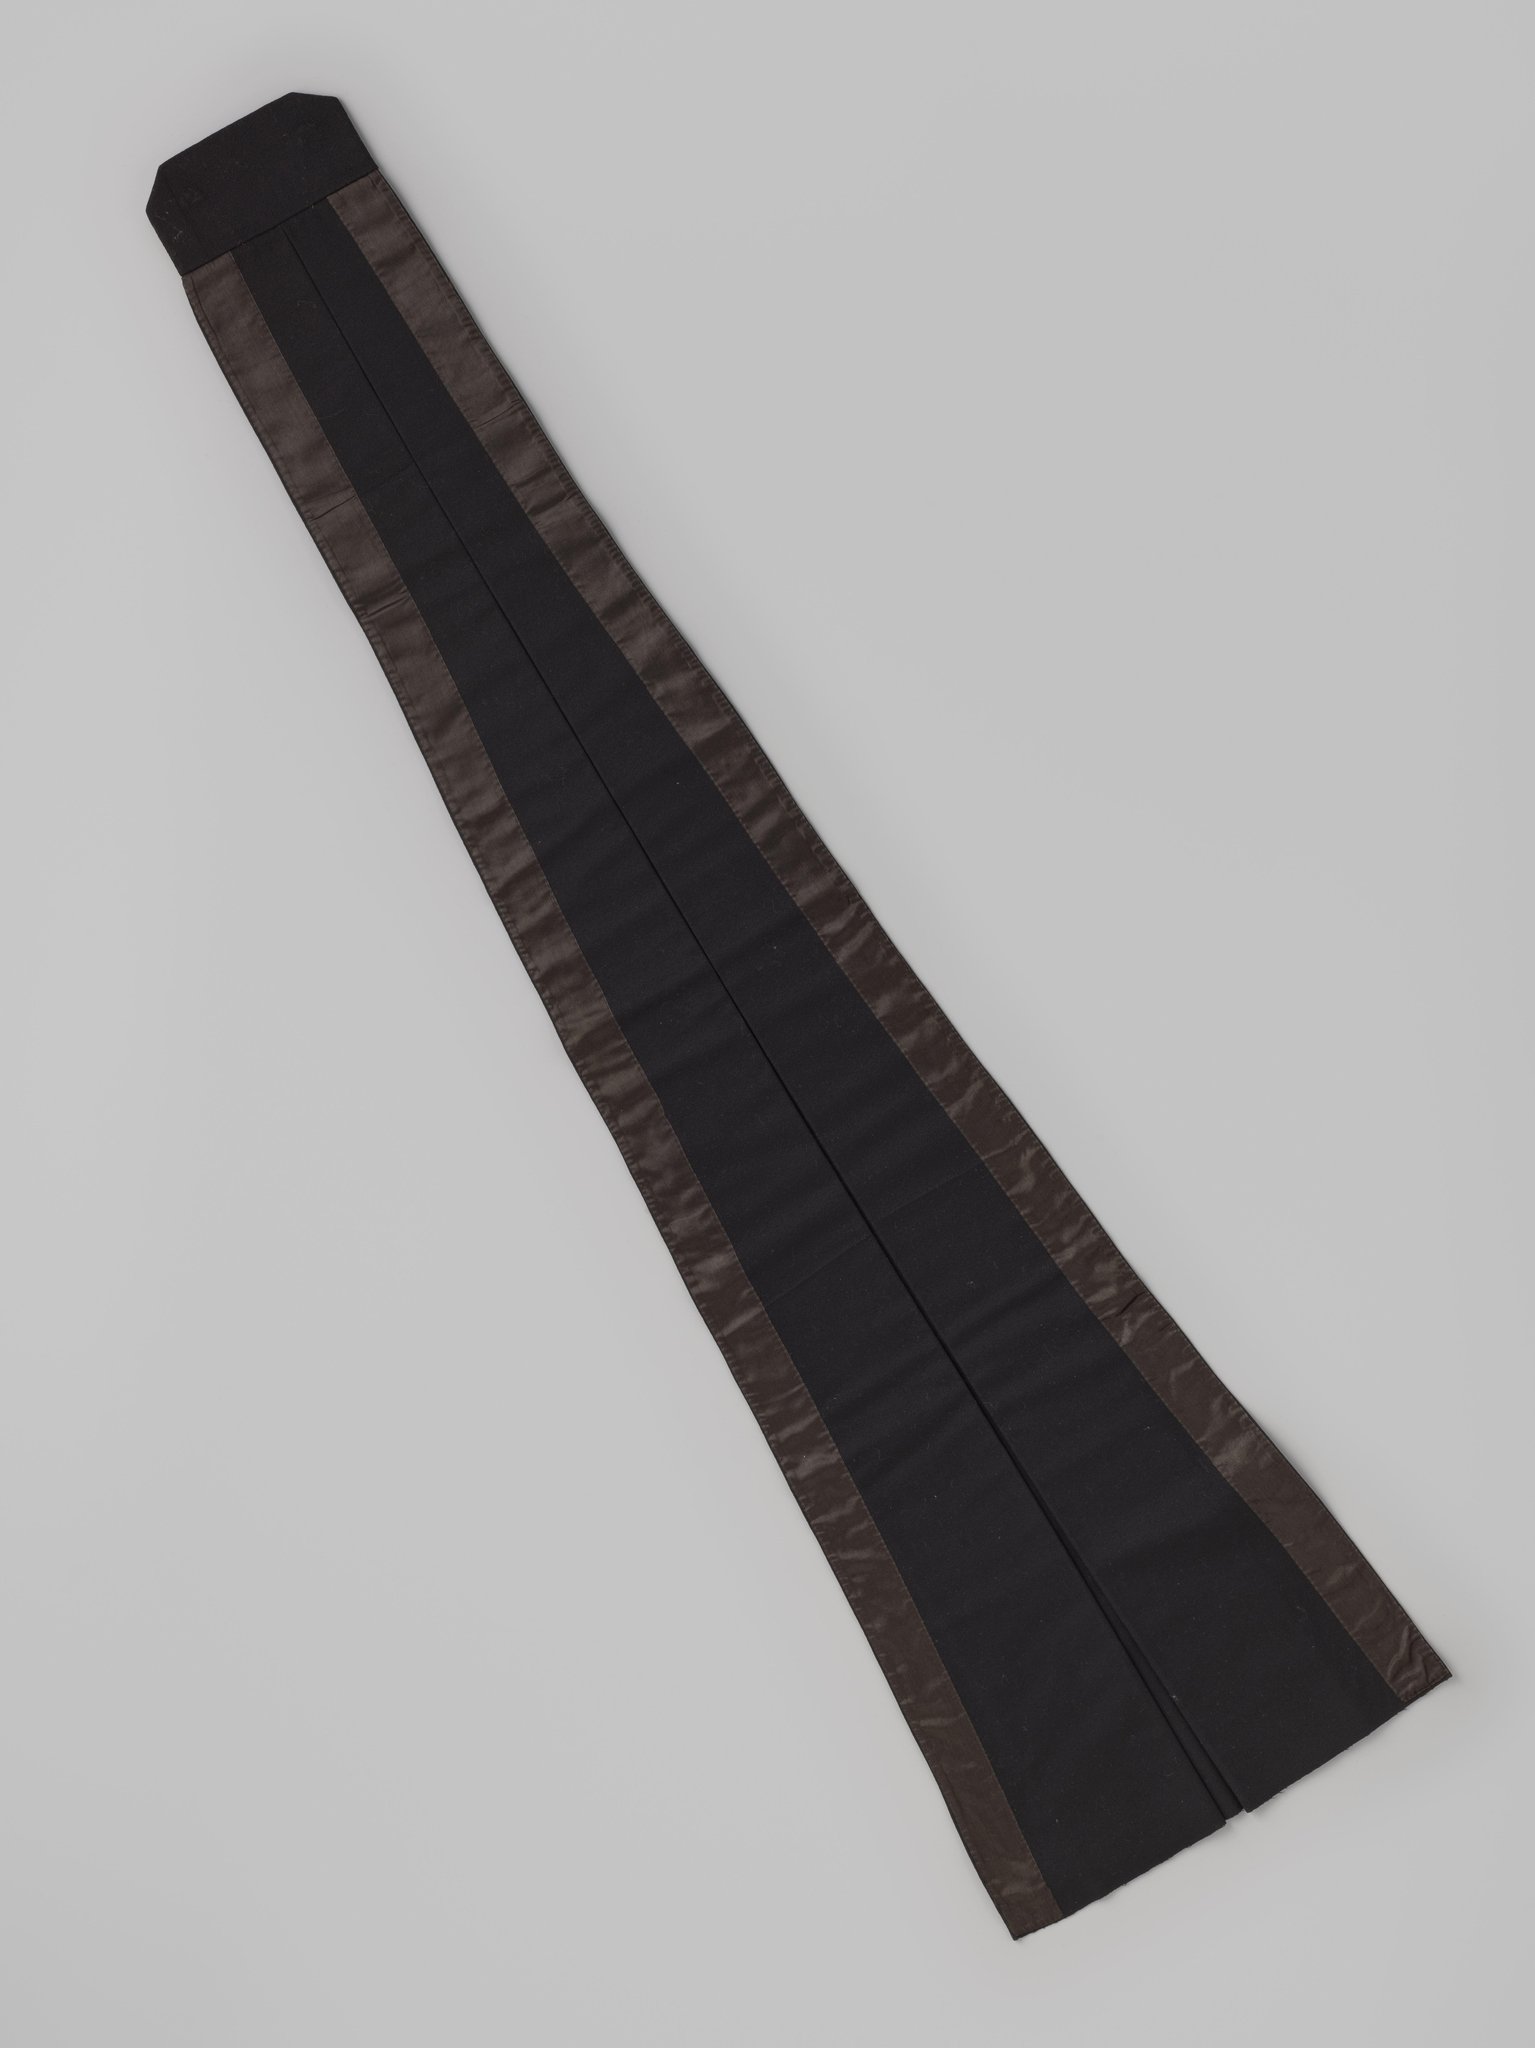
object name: mourning veil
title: Rouwlamfer van zwart laken, afgewerkt met een satijnen lint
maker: Anonymous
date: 1850-1900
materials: textile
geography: netherlands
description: Rouwlamfer van zwart laken en afgewerkt met satijnlint. Model-Een /Reep stof/ met smalle boven - en brede onderkna tis in een naar binnen gevouwen stolplooi geperst in genaaid. Bovenaan een verstevigd bevestingsstuk met twee ingenaaide haken voor om hoed (en lint of lussen?) te bevestigen. Versiering: Langs de buitenzijden in een satijnen lint opgenaaid. Toestand. Gaaf.